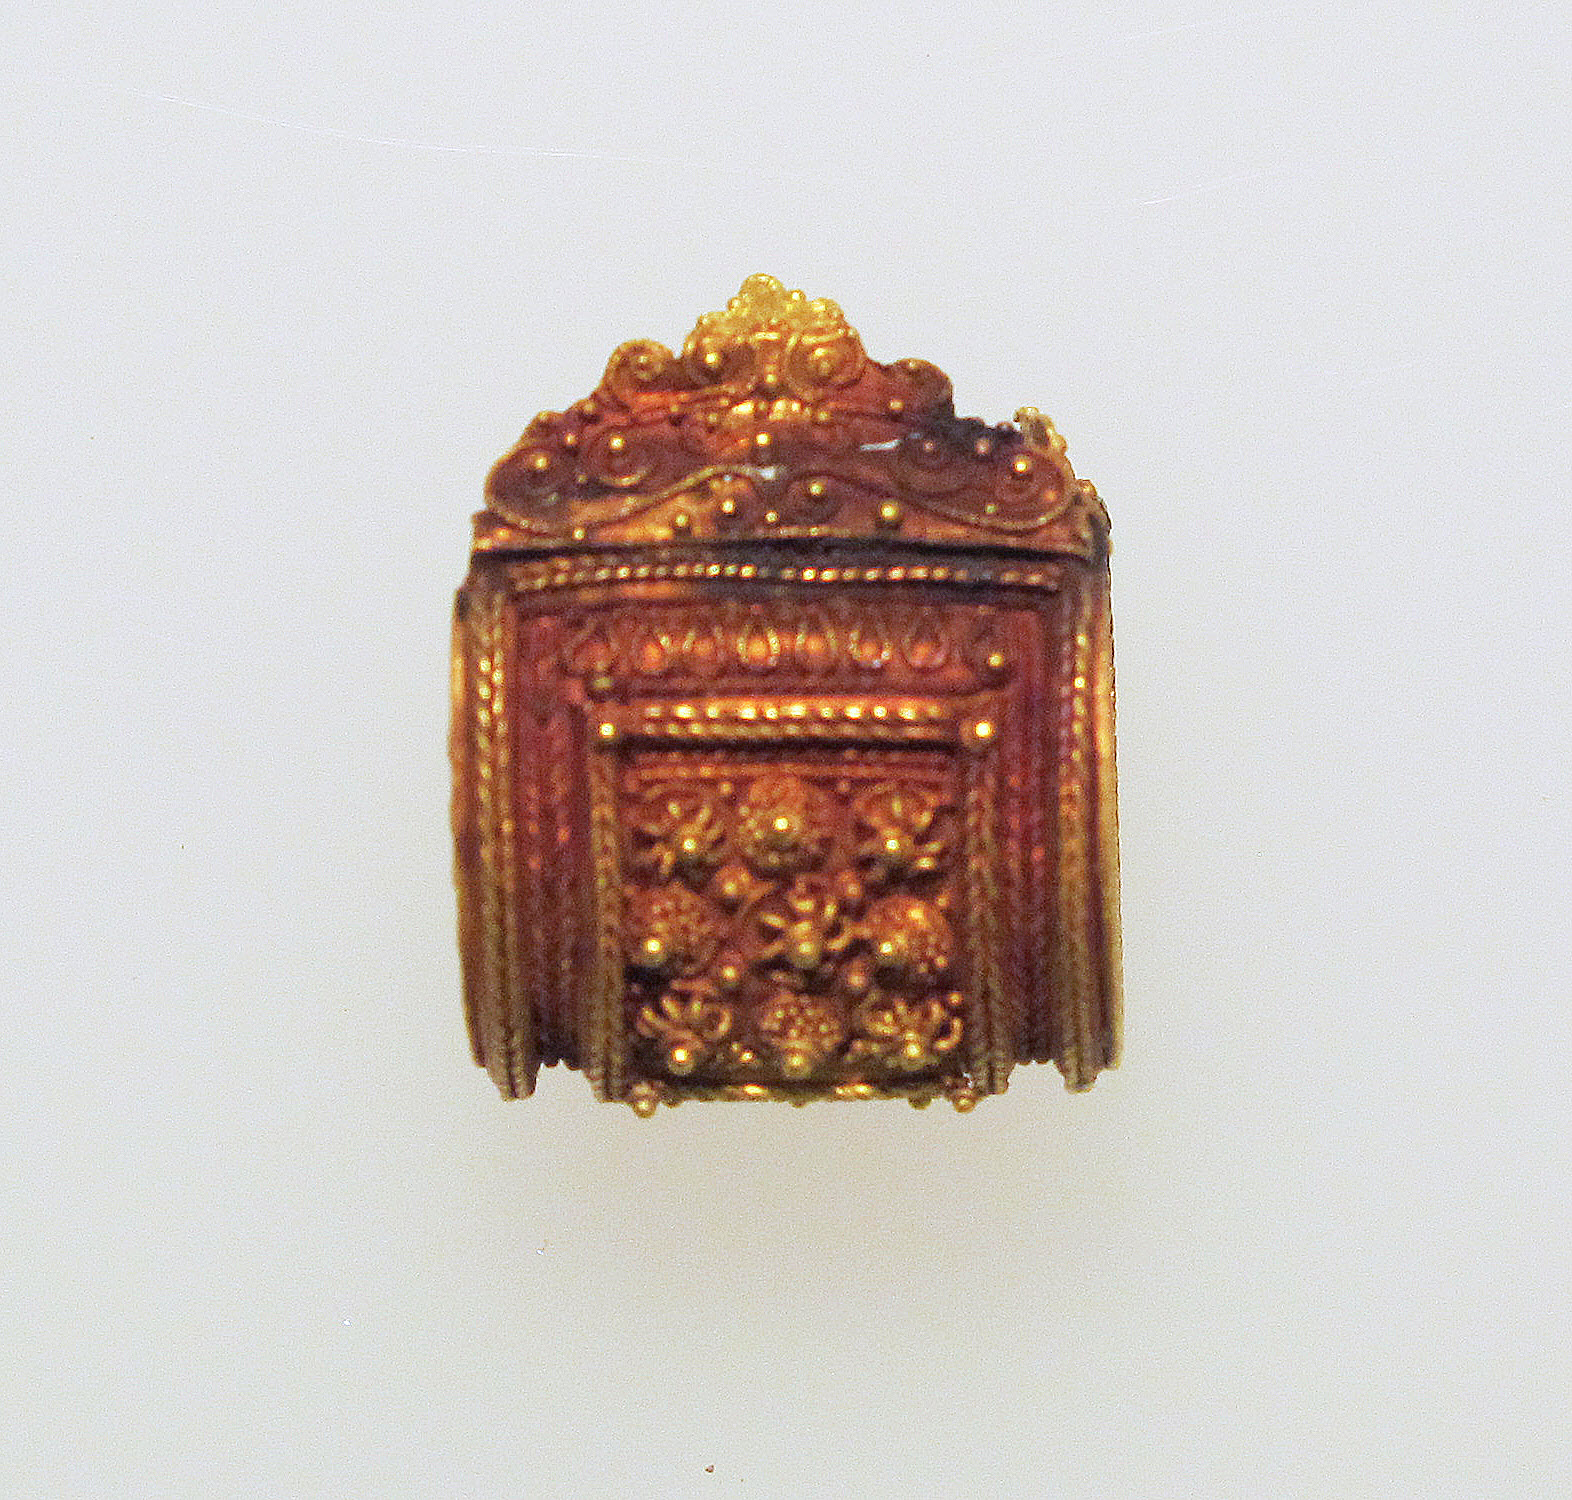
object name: earring, baule type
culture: etruscan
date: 700-401 BCE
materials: gold